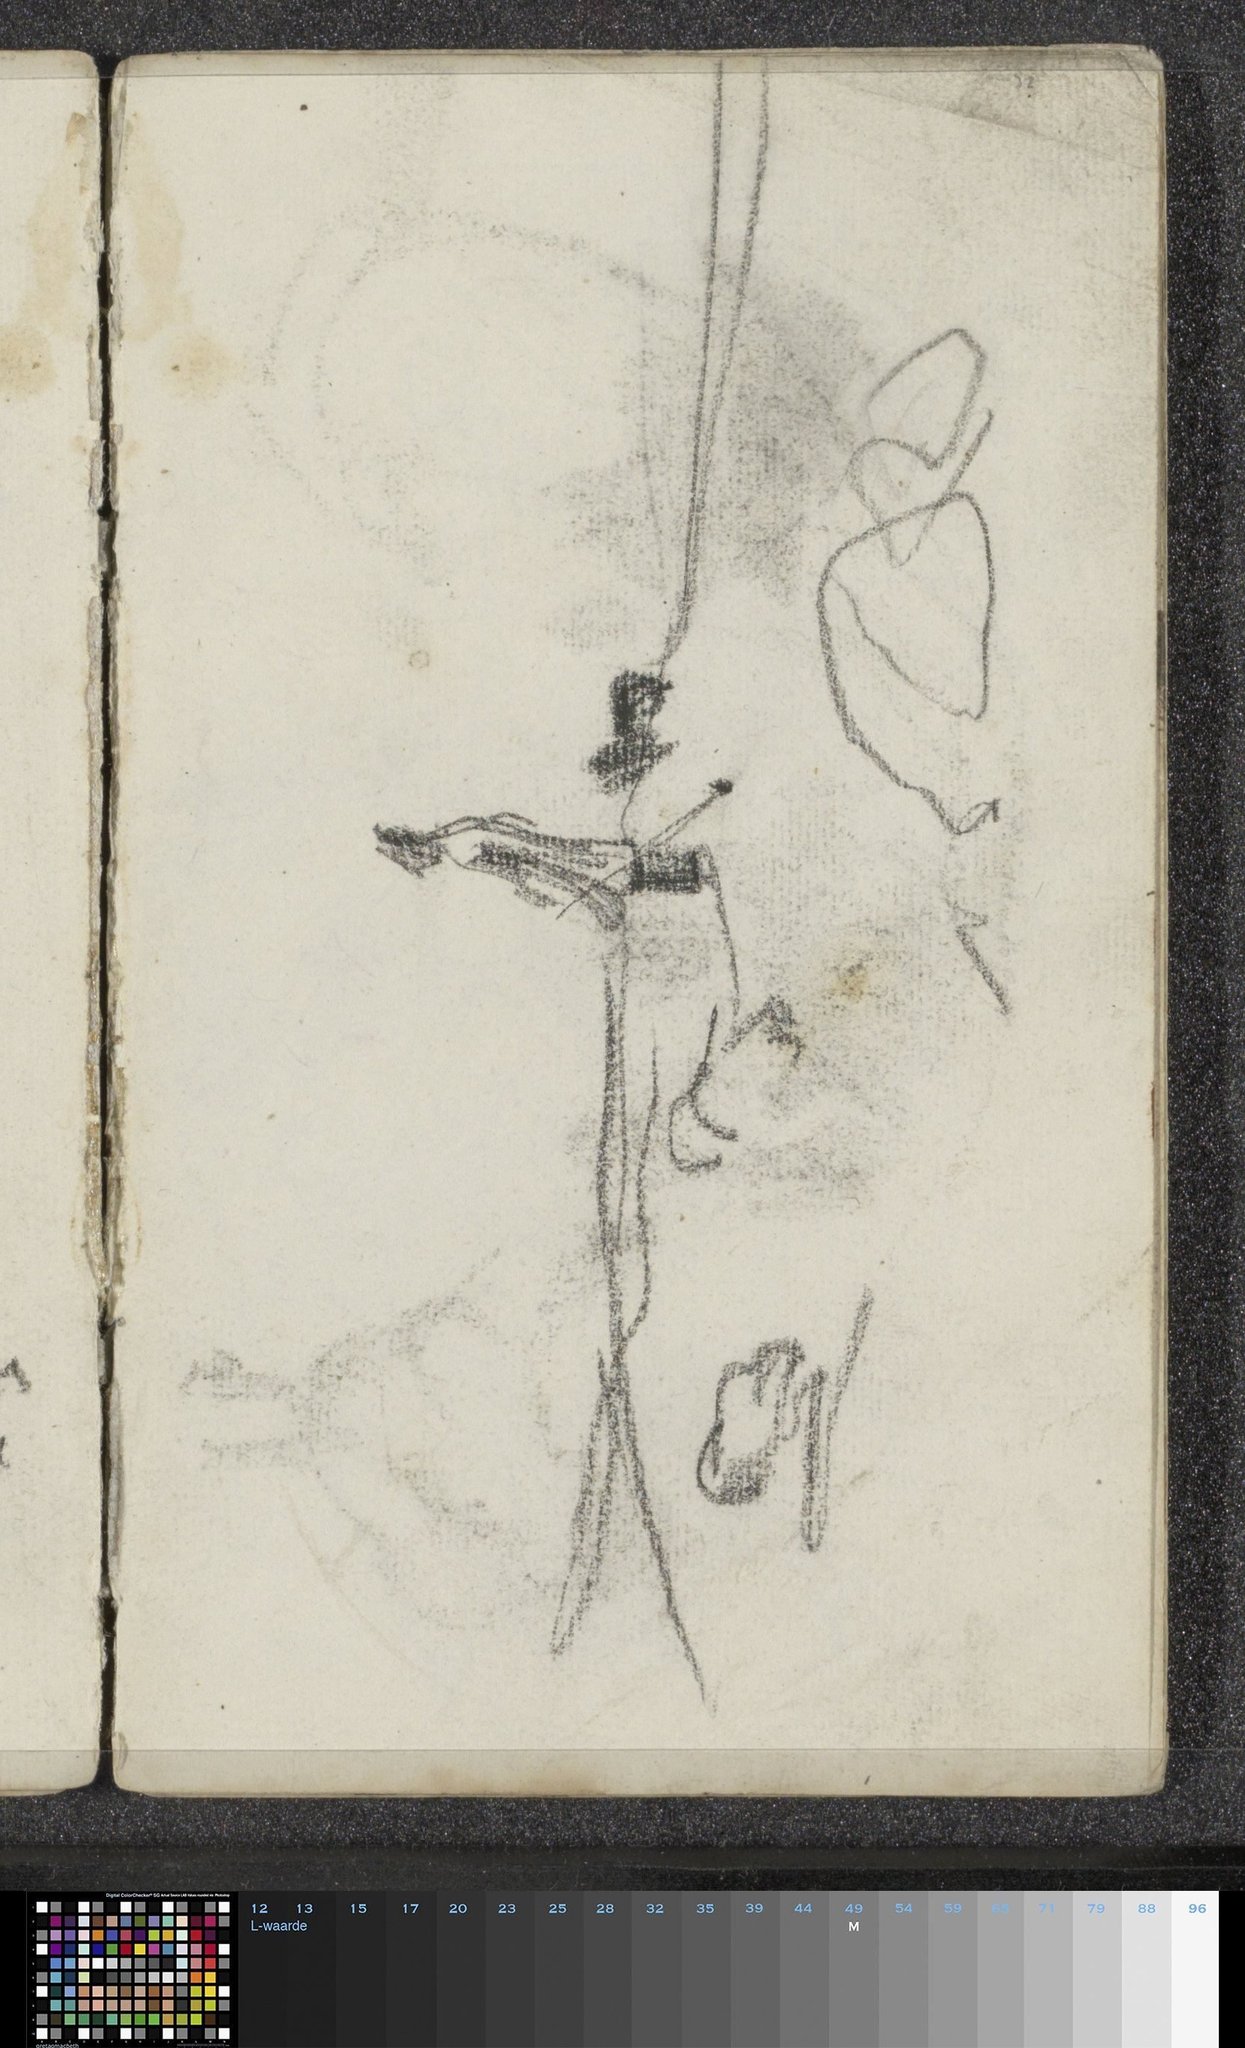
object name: sketchbook leaf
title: Figuur in een landschap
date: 1881-1883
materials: chalk, paper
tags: standing figure, landscapes in the temperate zone, cattle driving, cattle driver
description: Mogelijk een schaapherder. Pagina 32 uit een schetsboek met 27 bladen